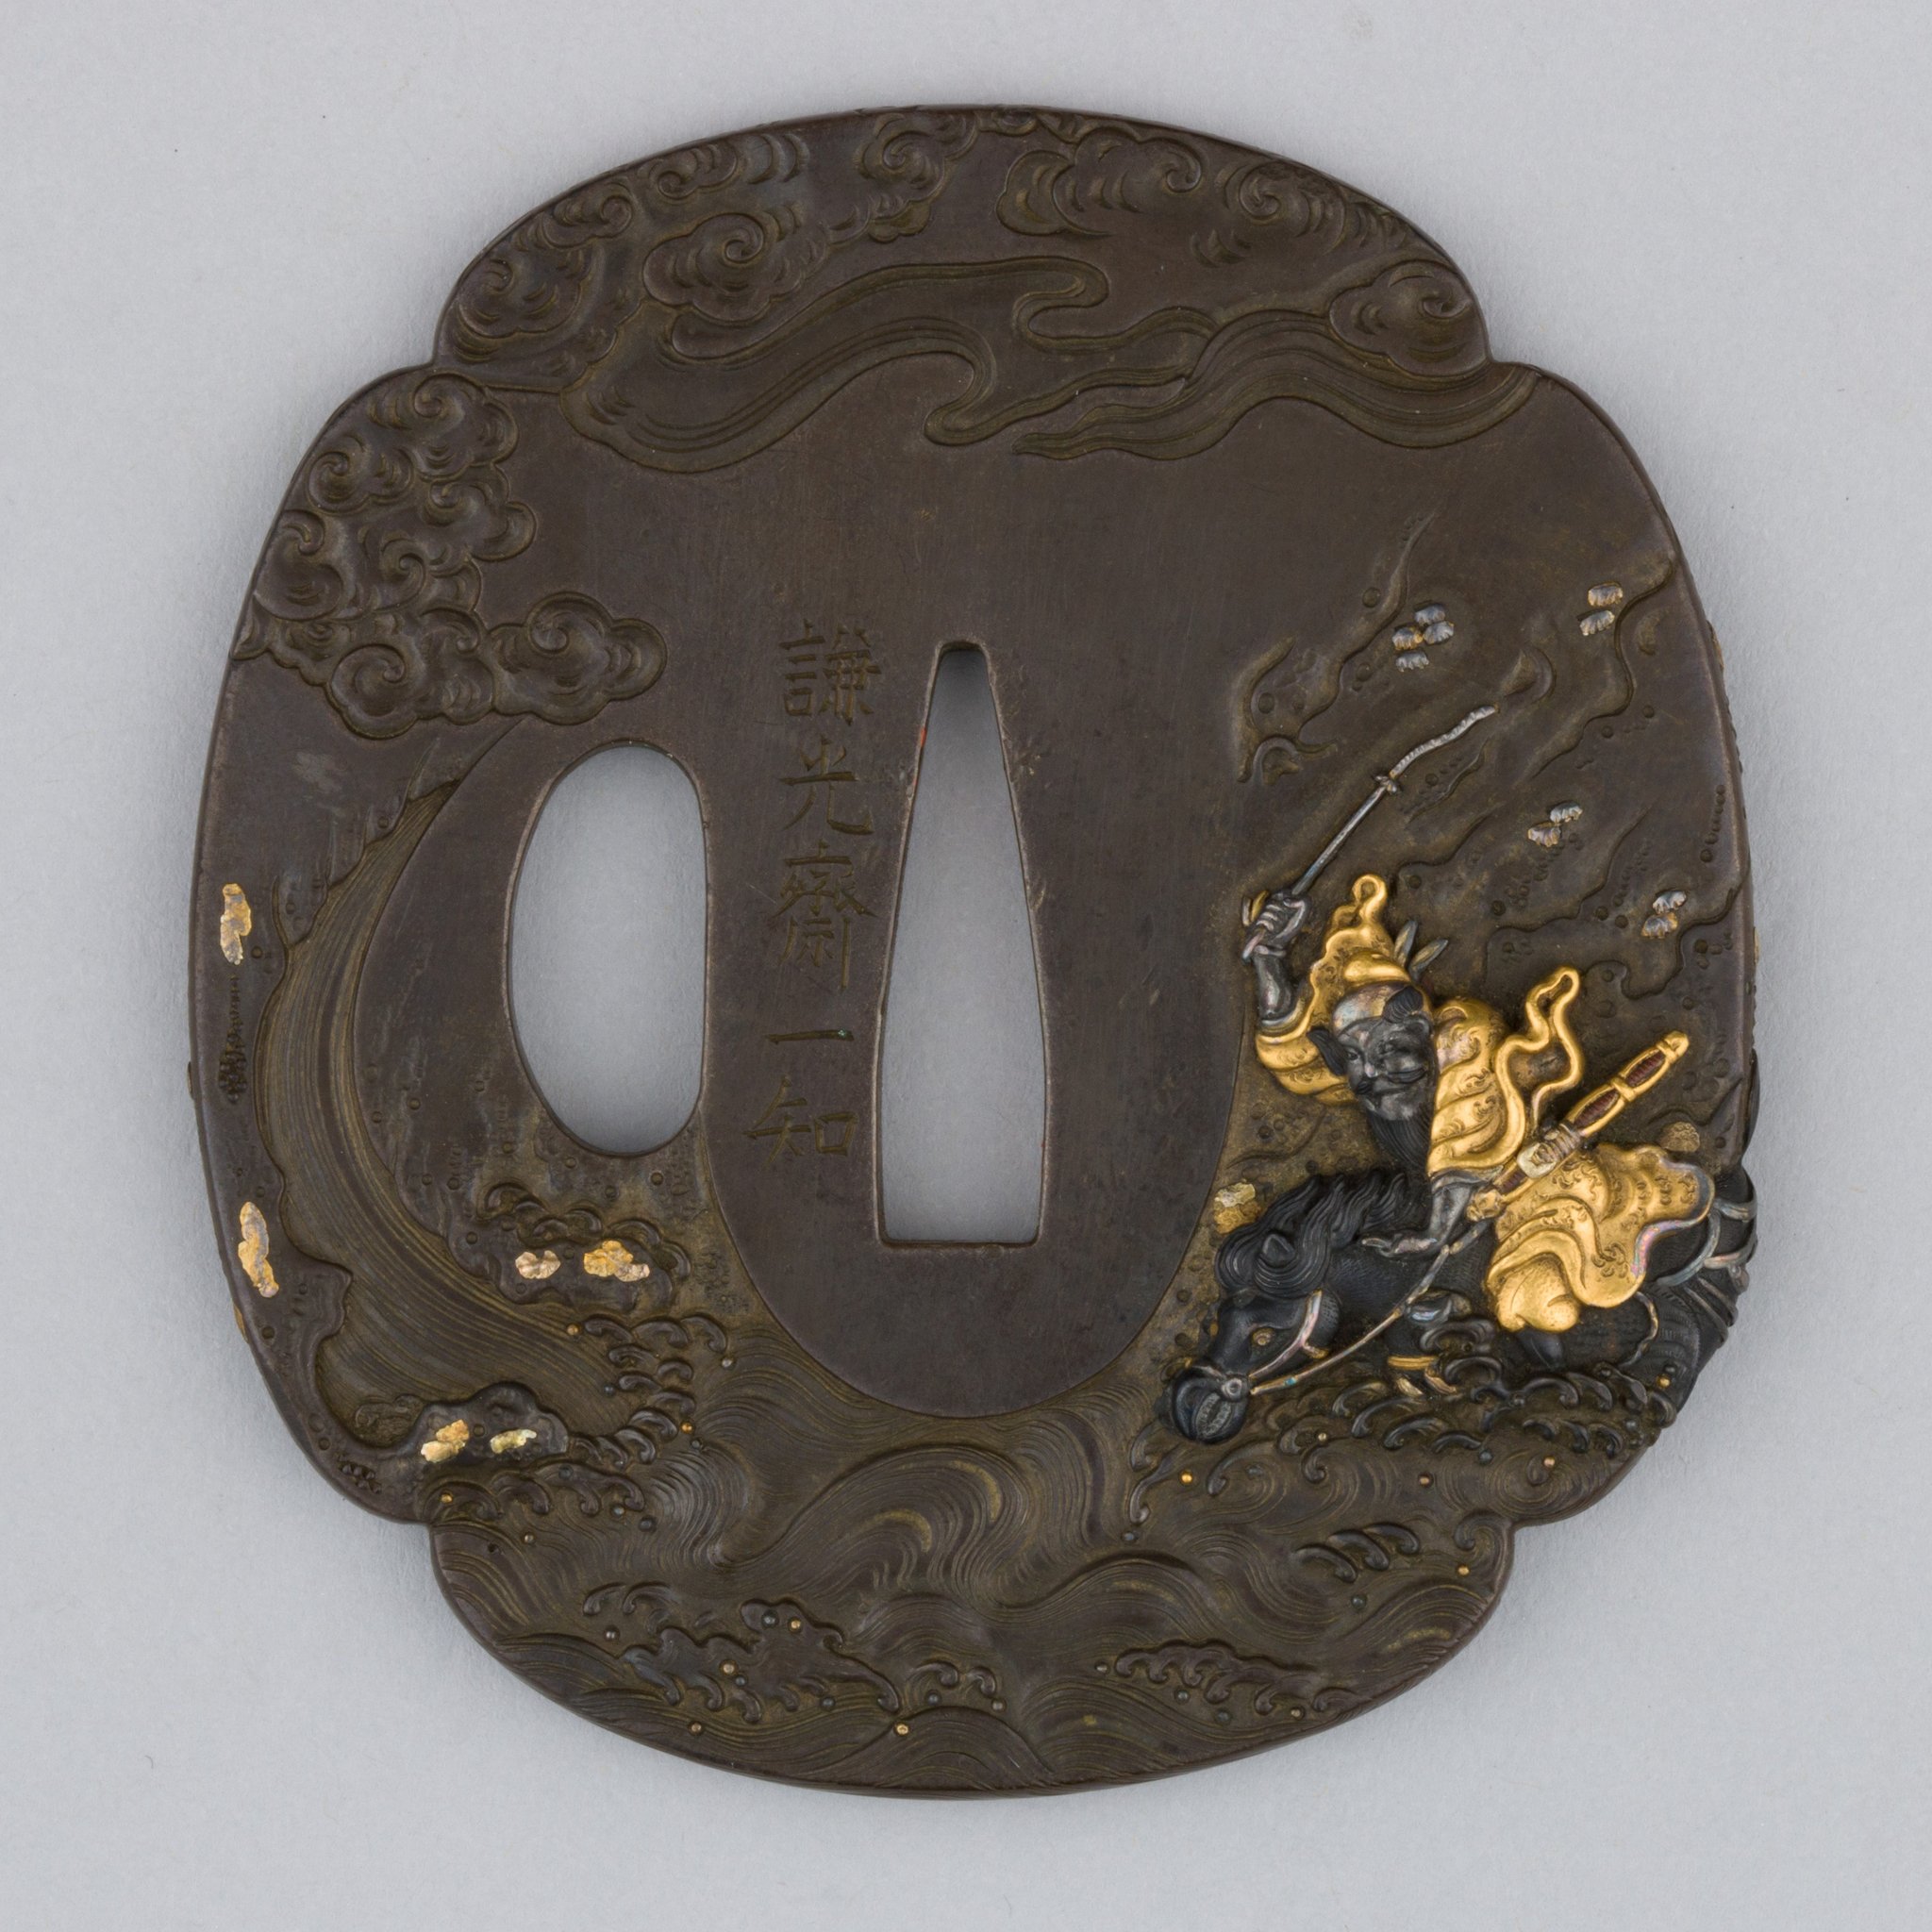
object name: sword guard tsuba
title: Sword Guard (Tsuba)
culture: japanese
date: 1701-1800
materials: copper, gold alloy, silver alloy, gold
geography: japan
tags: men,horses